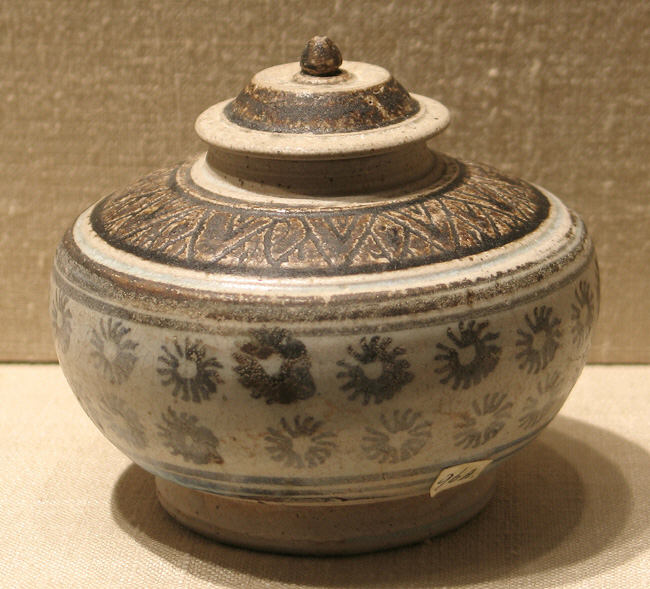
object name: covered jar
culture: thai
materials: earthenware, glaze, iron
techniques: underglaze